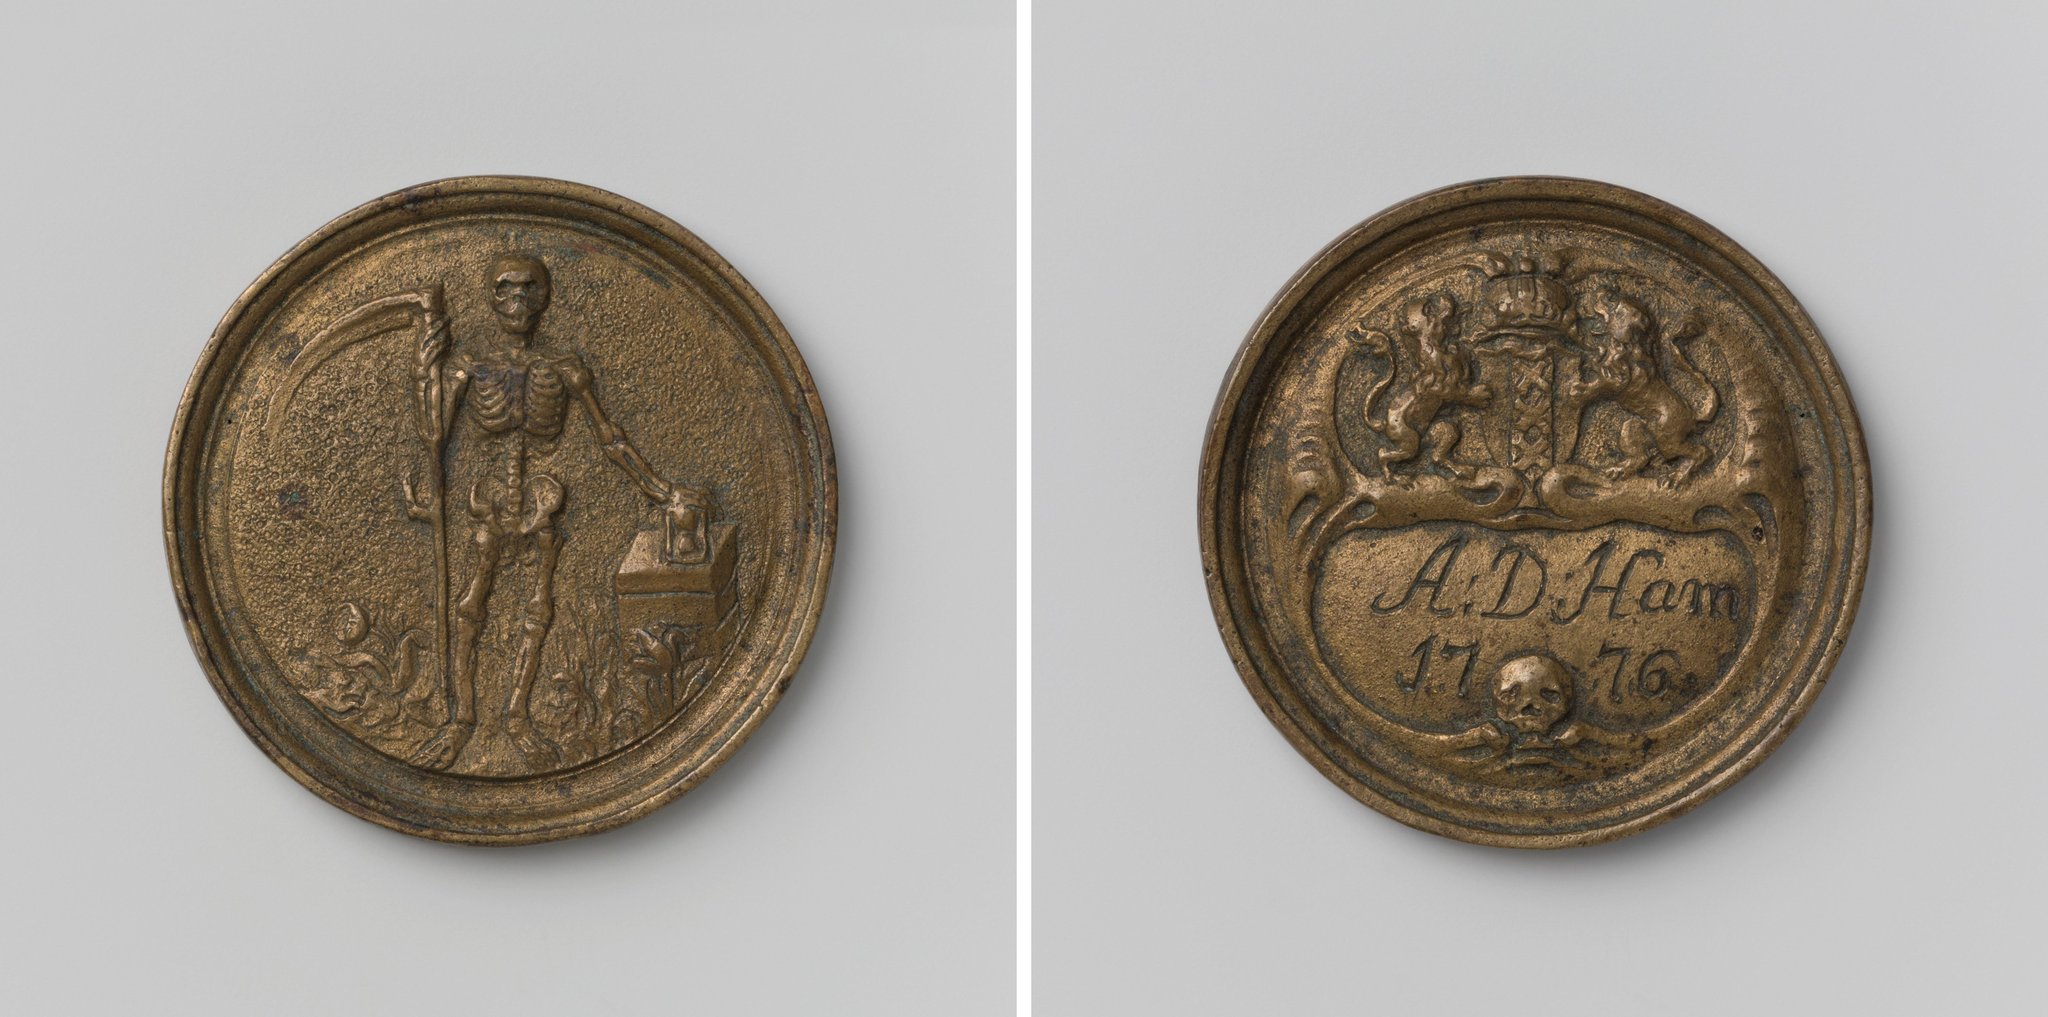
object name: medal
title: Chirurgijnsgilde van Amsterdam, gildepenning van A.D. Ham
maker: Anonymous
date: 1776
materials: brass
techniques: casting, engraving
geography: amsterdam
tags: amsterdam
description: Messing penning. Voorzijde: Dood, afgebeeld als geraamte, in bloemenveld met zeis in rechterhand en met linkerhand op zandloper, die op sokkel staat. Keerzijde: gekroond wapenschild, geflankeerd door twee leeuwen boven cartouche met opschrift en doodshoofd